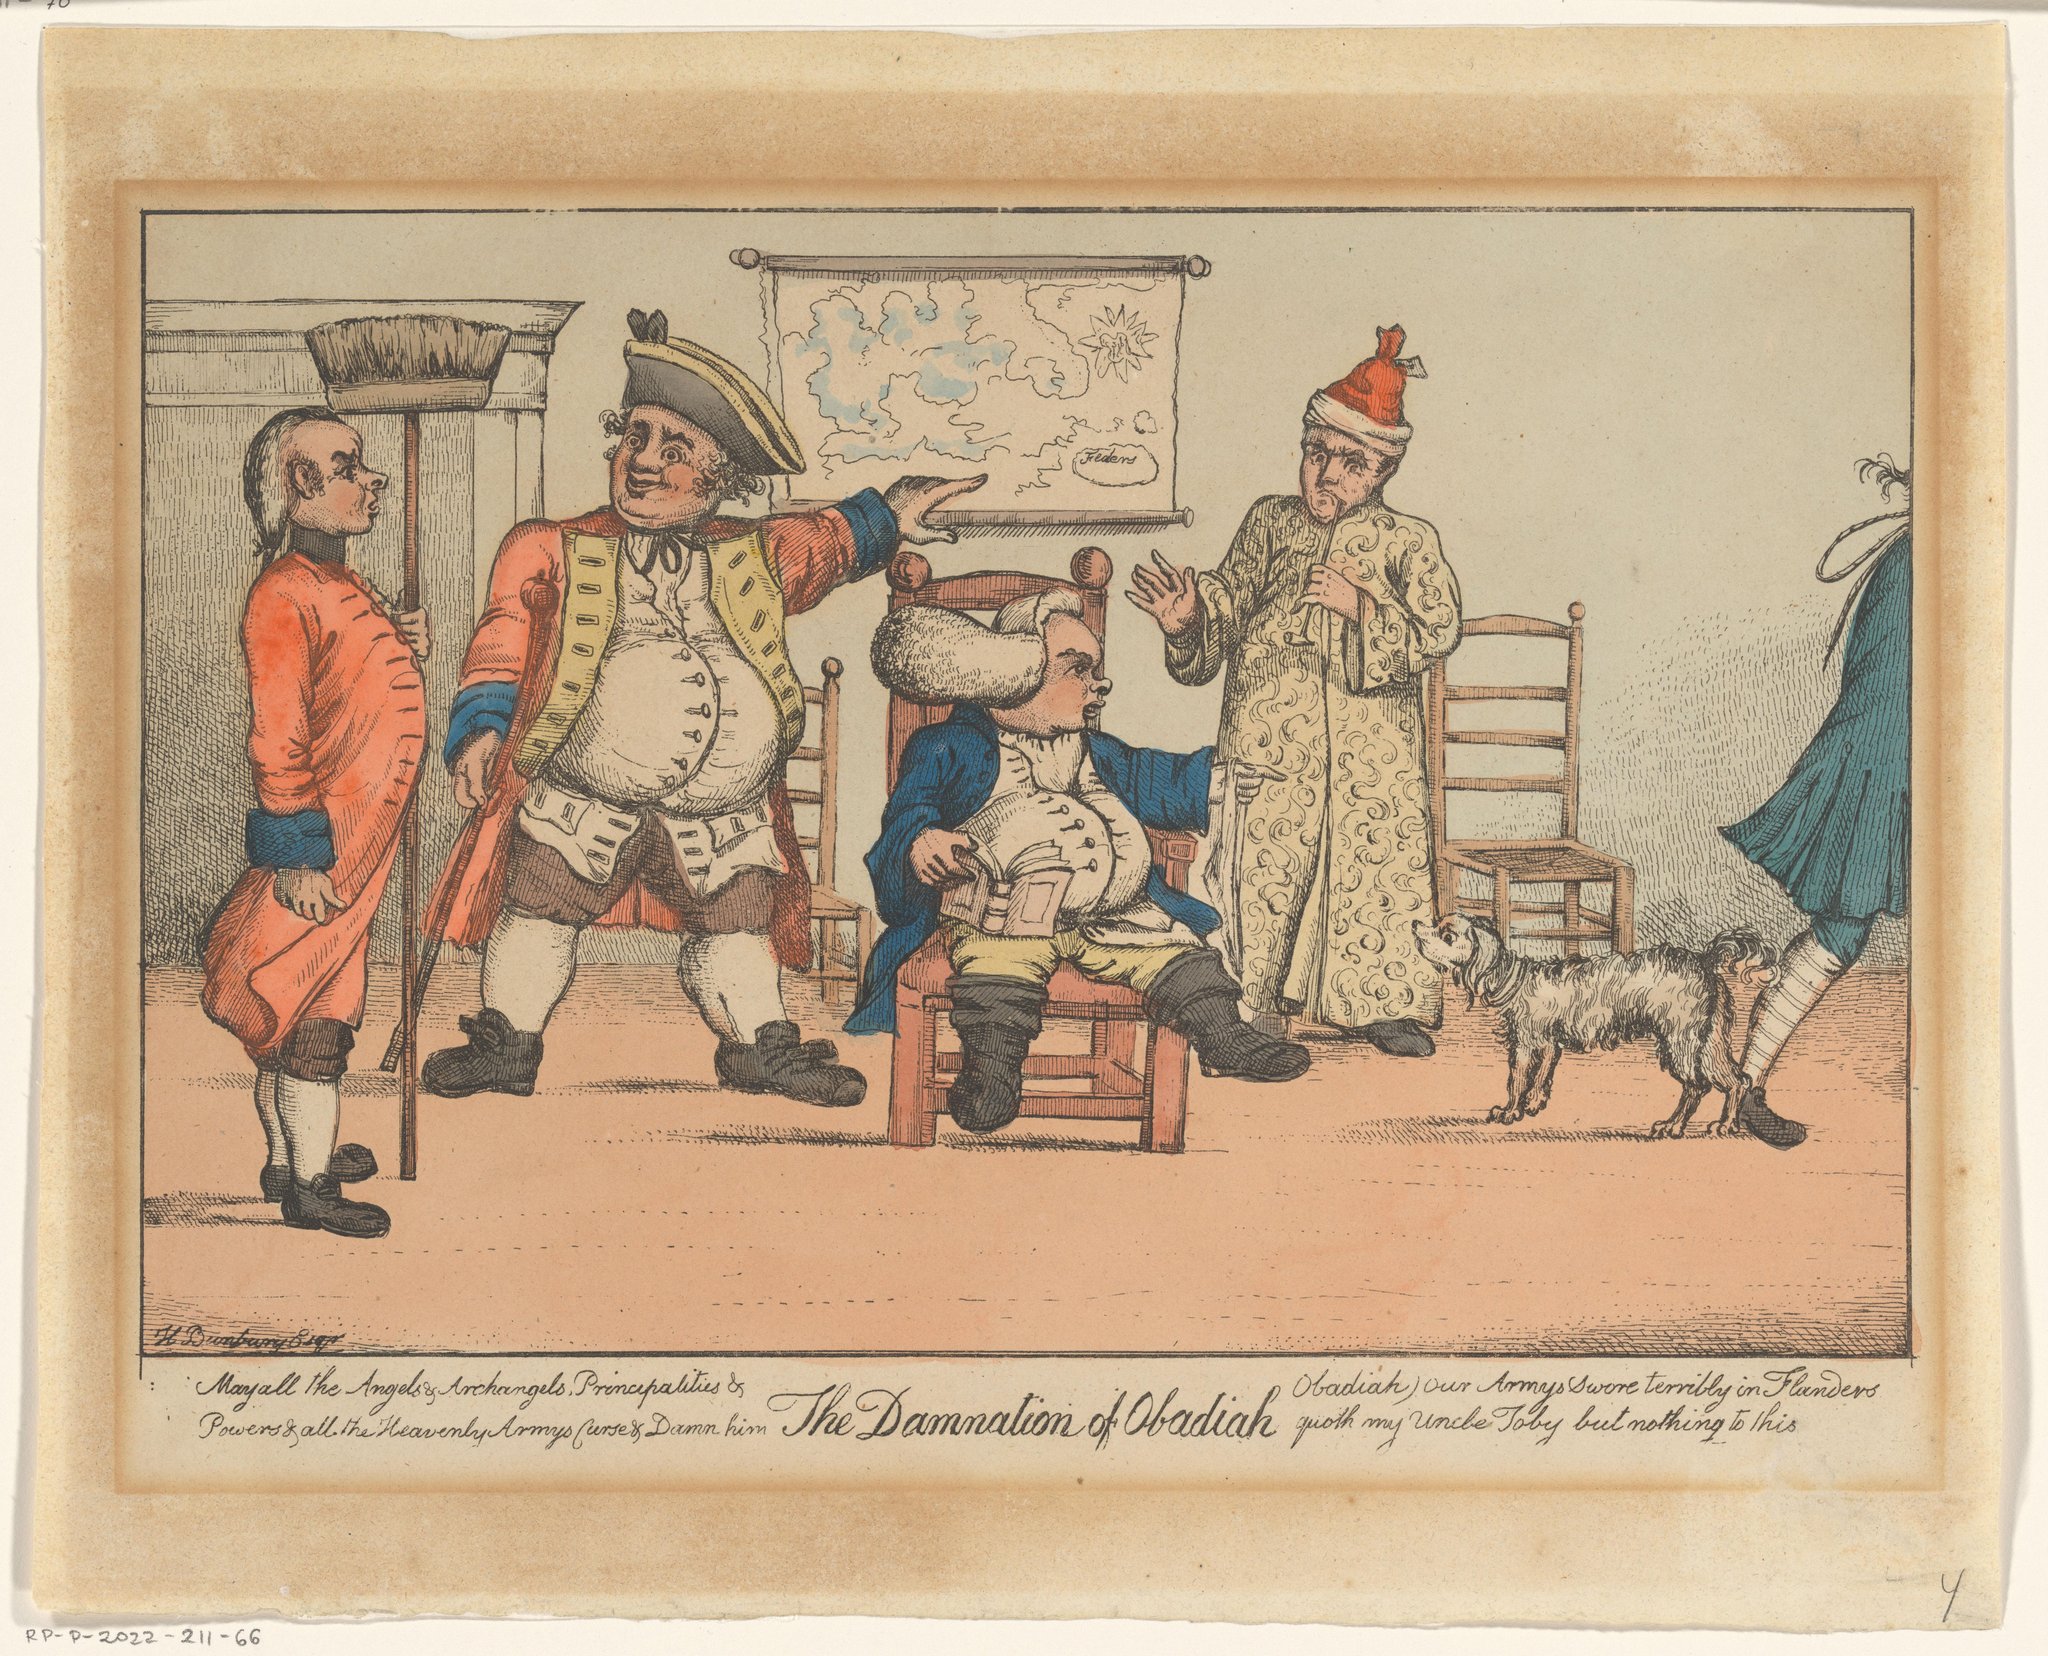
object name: book illustration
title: The Damnation of Obadiah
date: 1759-1767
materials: paper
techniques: etching, hand coloring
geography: london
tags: caricatures (human types), (scenes from) specific works of literature (with author, title), military training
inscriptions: collector's mark: Lugt 2228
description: Dr. Slop, zittend in een leunstoel met in zijn linkerhand het boek dat een formulier van excommunicatie bevat, wijst naar Obadiah die het beeld uit loopt, alleen één been en zijn rug zijn nog zichtbaar. Een zakdoek hangt over de gesneden linkerduim van de dokter. Achter hem staat mr. Shandy, in kamerjas en nachtmuts, een lange pijp rokend, hij fronst en steekt zijn hand uit uit protest tegen de verwensingen van de dokter. Oom Toby, met zijn kruk onder zijn arm, staat links en wijst naar een kaart van Vlaanderen die boven het hoofd van Dr. Slop aan de muur hangt. Hij draait zich om om met korporaal Trim te spreken, die links staat en een lange bezem vasthoudt. Een illustratie voor Laurence Sterne’s The Life and Opinions of Tristram Shandy, Gentleman (York 1759- 1767).